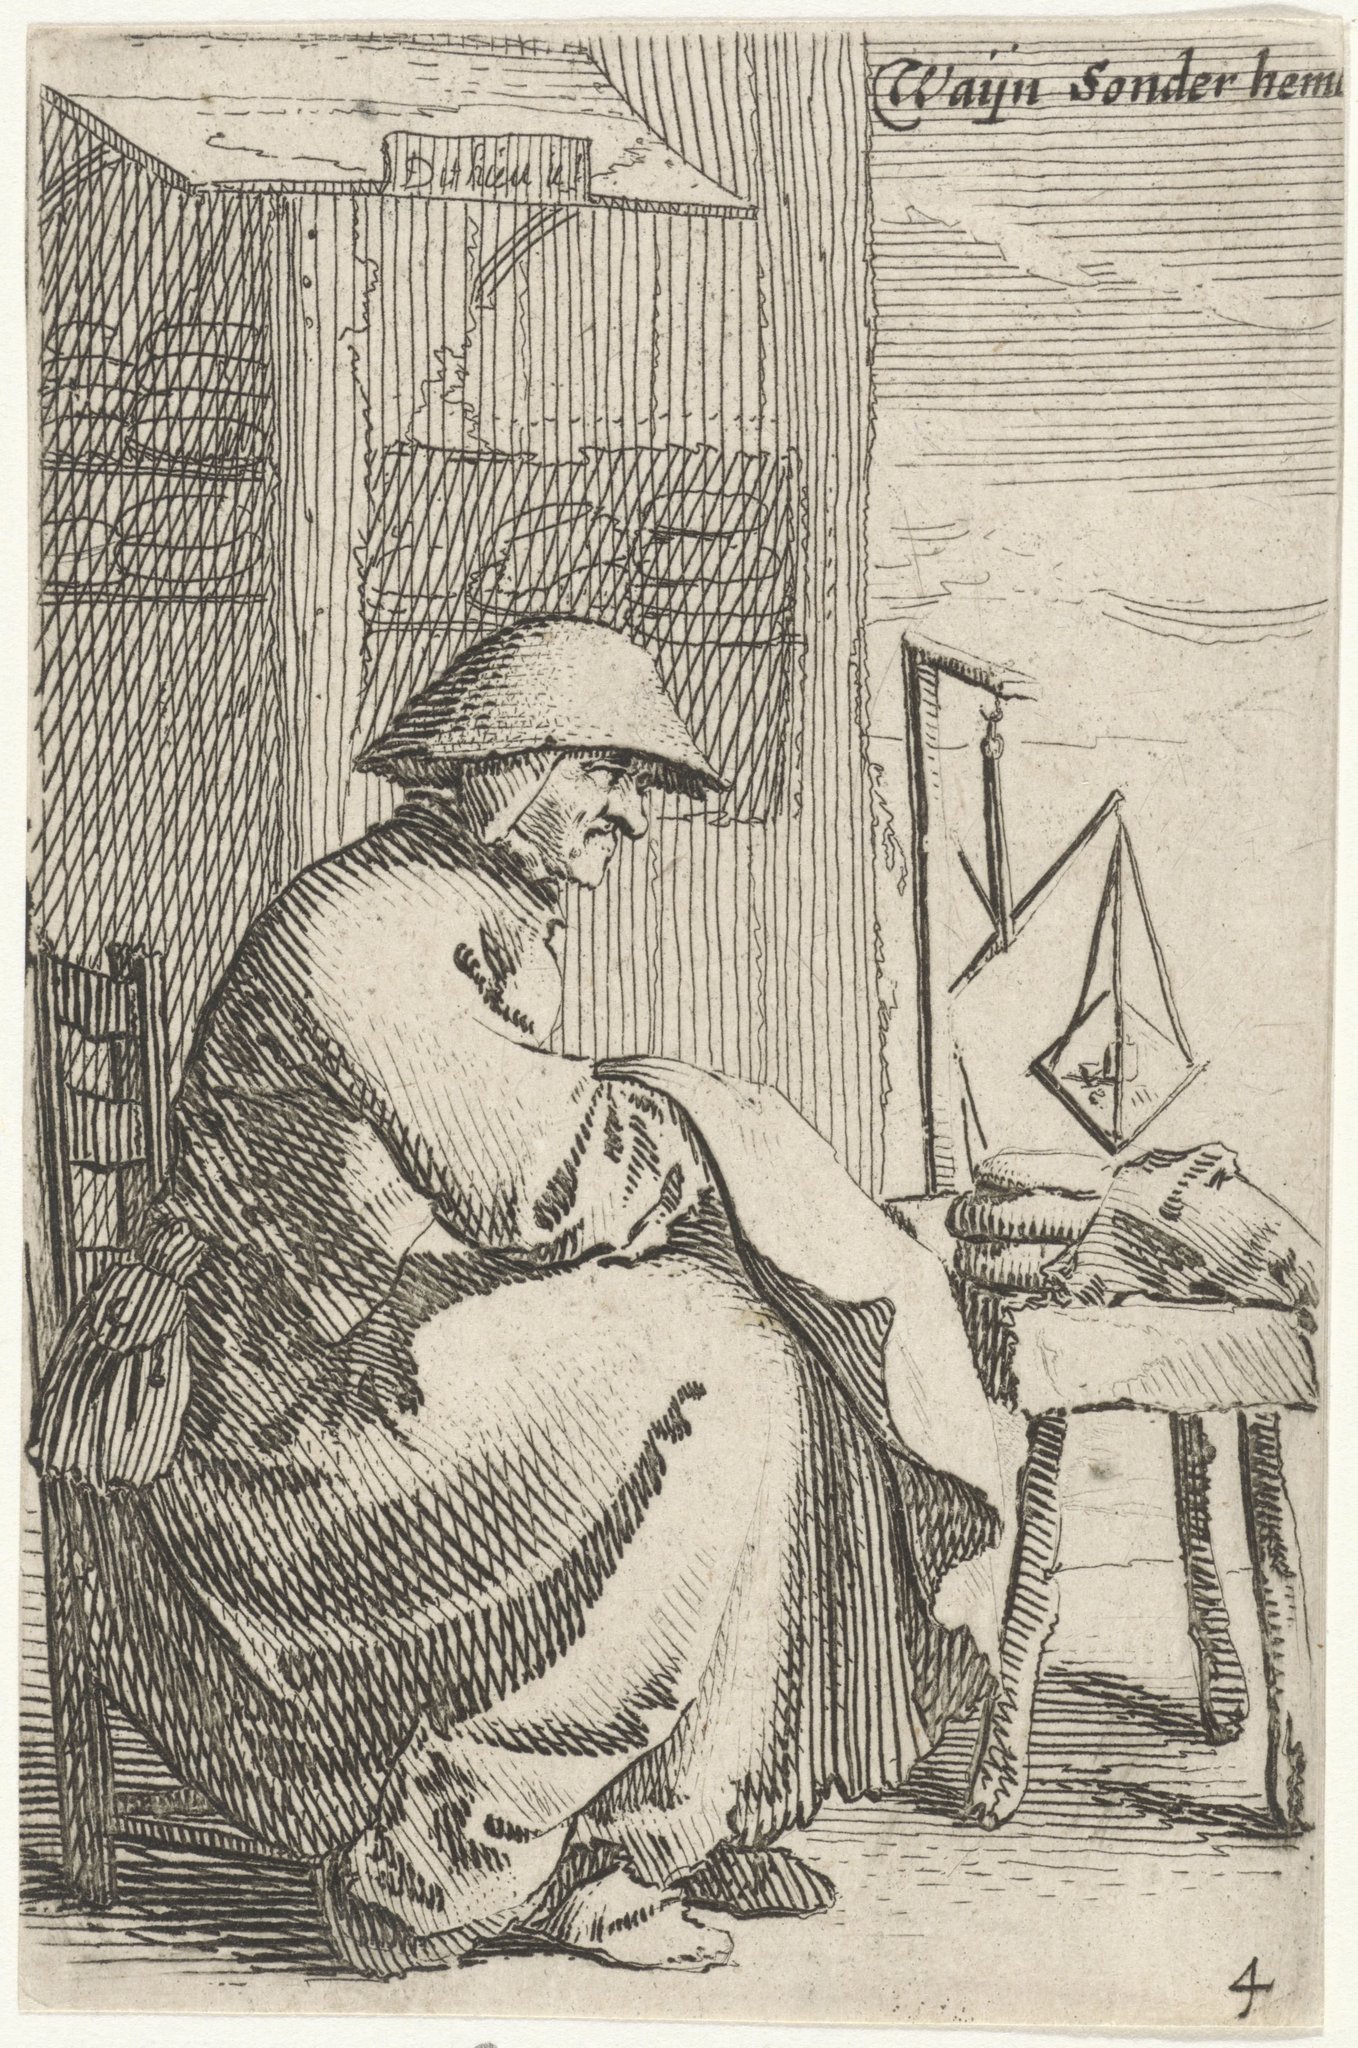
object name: print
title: T'Leven Der Boeren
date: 1630-1665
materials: paper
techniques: engraving, etching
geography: amsterdam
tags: farmers, weighing-instruments, textile fabric, cloth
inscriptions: collector's mark: Lugt 2228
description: Zie tevens de vijf overgeleverde spiegelbeeldige kopieën naar deze serie door Reinhard Voskens.